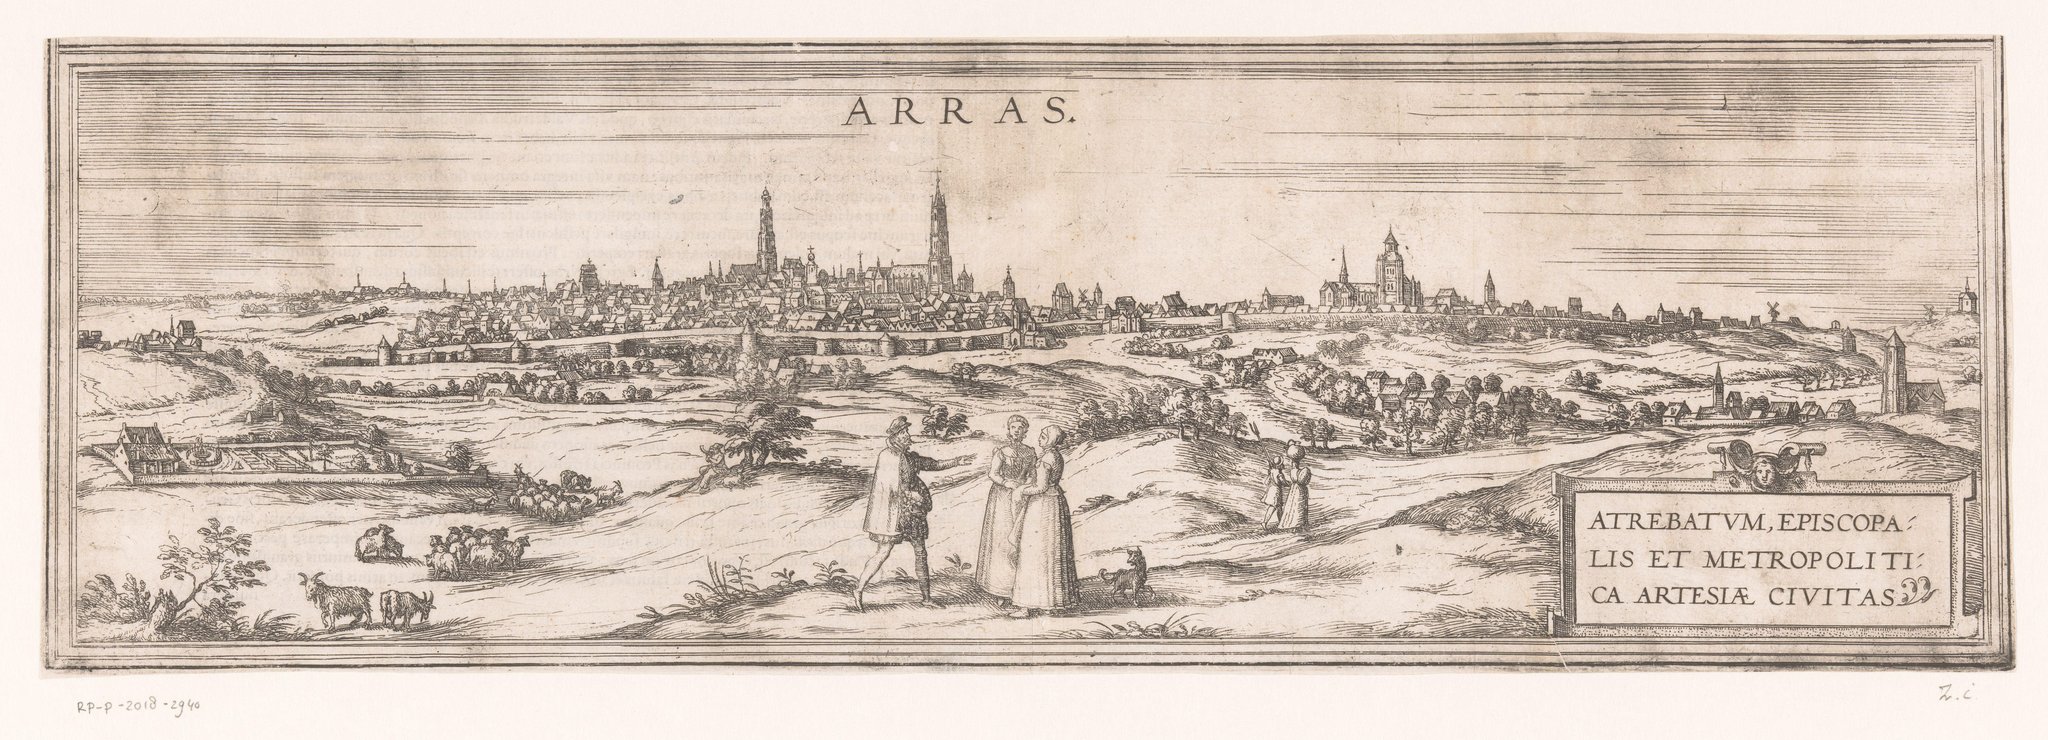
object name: book illustration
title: Gezicht op Arras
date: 1572-1657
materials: paper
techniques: engraving, etching, letterpress printing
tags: city-view, and landscape with man-made constructions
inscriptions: collector's mark: Lugt 2228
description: Prent uit: Braun, Georg; Hogenberg, Frans. Civitates Orbis Terrarum, Liber Primus. Keulen: Braun & Hogenberg, 1572.